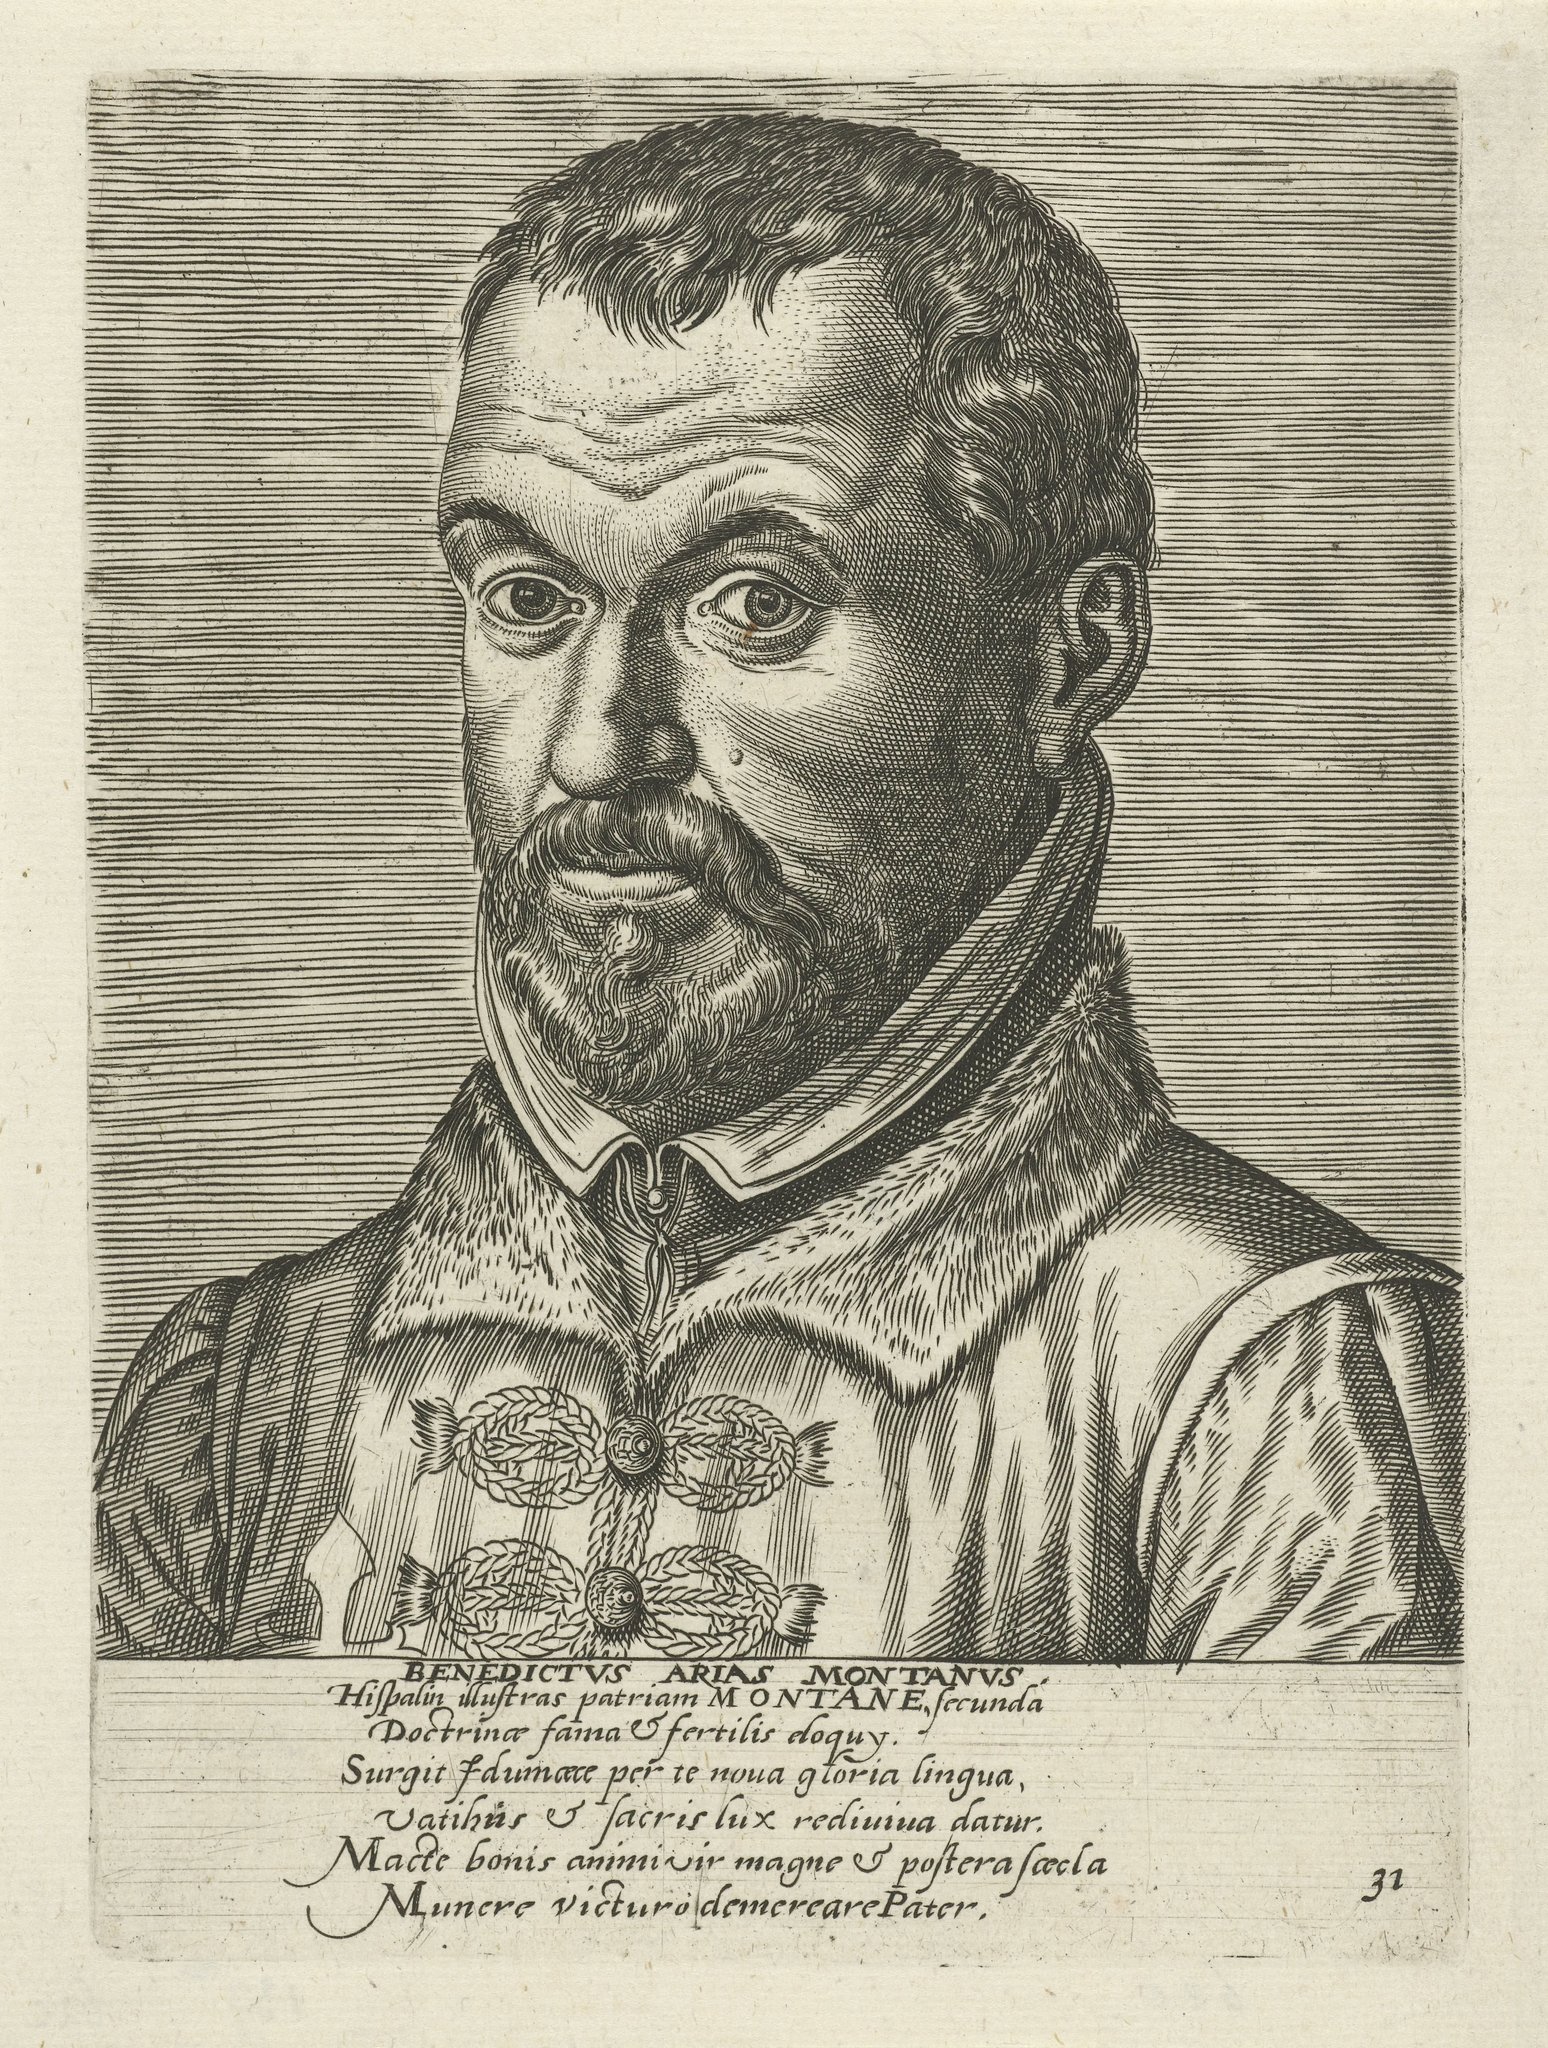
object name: print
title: Benedictvs Arias Montanvs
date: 1572-1662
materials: paper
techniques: engraving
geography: antwerp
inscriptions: collector's mark: Lugt 2228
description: Portret van Benito Arias Montano, een Spaanse schrijver en theoloog. Buste naar rechts. De prent heeft een Latijns onderschrift.